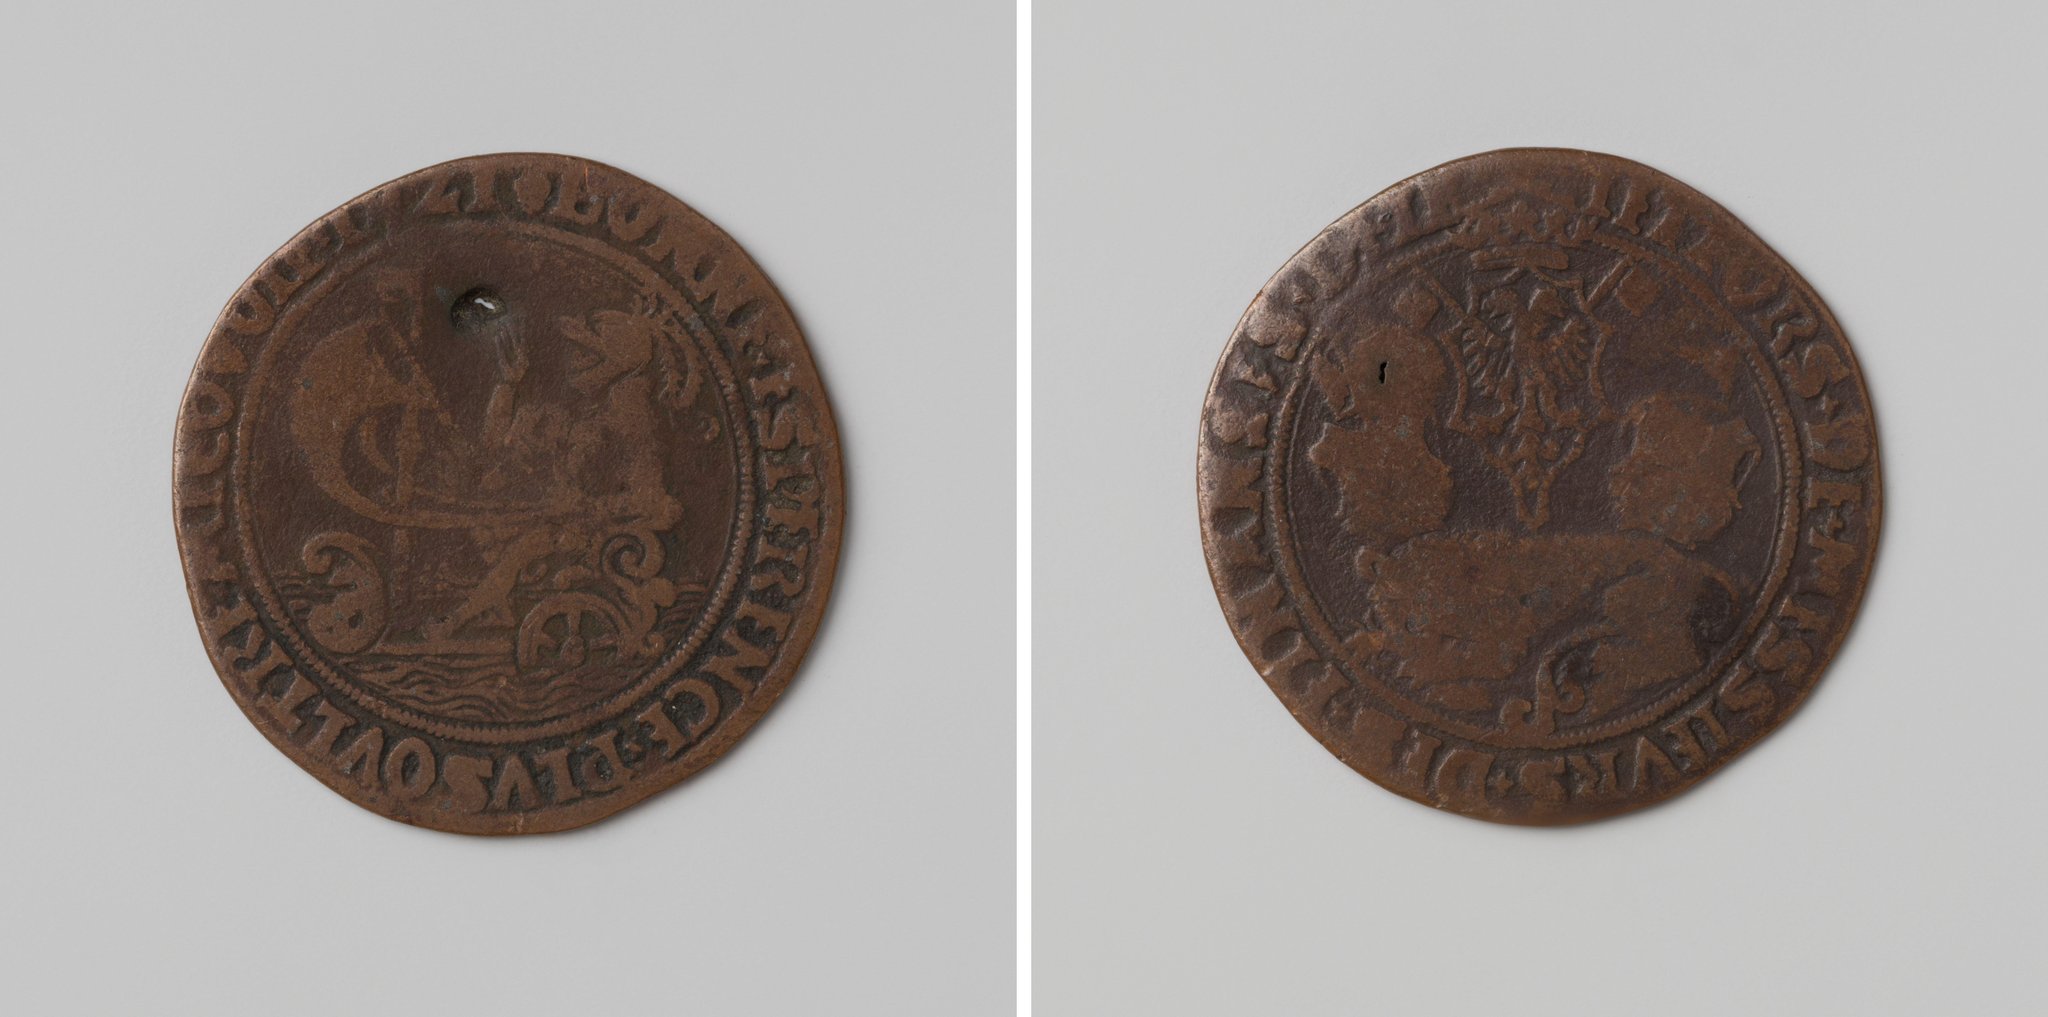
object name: jeton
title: Overwinningen van Karel V, Duits keizer, in de oorlog tegen Frankrijk, rekenpenning van de raad van Financien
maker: Anonymous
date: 1521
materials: copper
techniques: striking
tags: ghent, charles v (holy roman emperor and king of spain), netherlands, italy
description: Koperen penning. Voorzijde: Karel V in harnas, zittend in zeilbootje binnen omschrift. Keerzijde: leeuw, liggend voor gekroond wapenschild, geflankeerd door twee aan bijlen hangende harnassen binnen omschrift